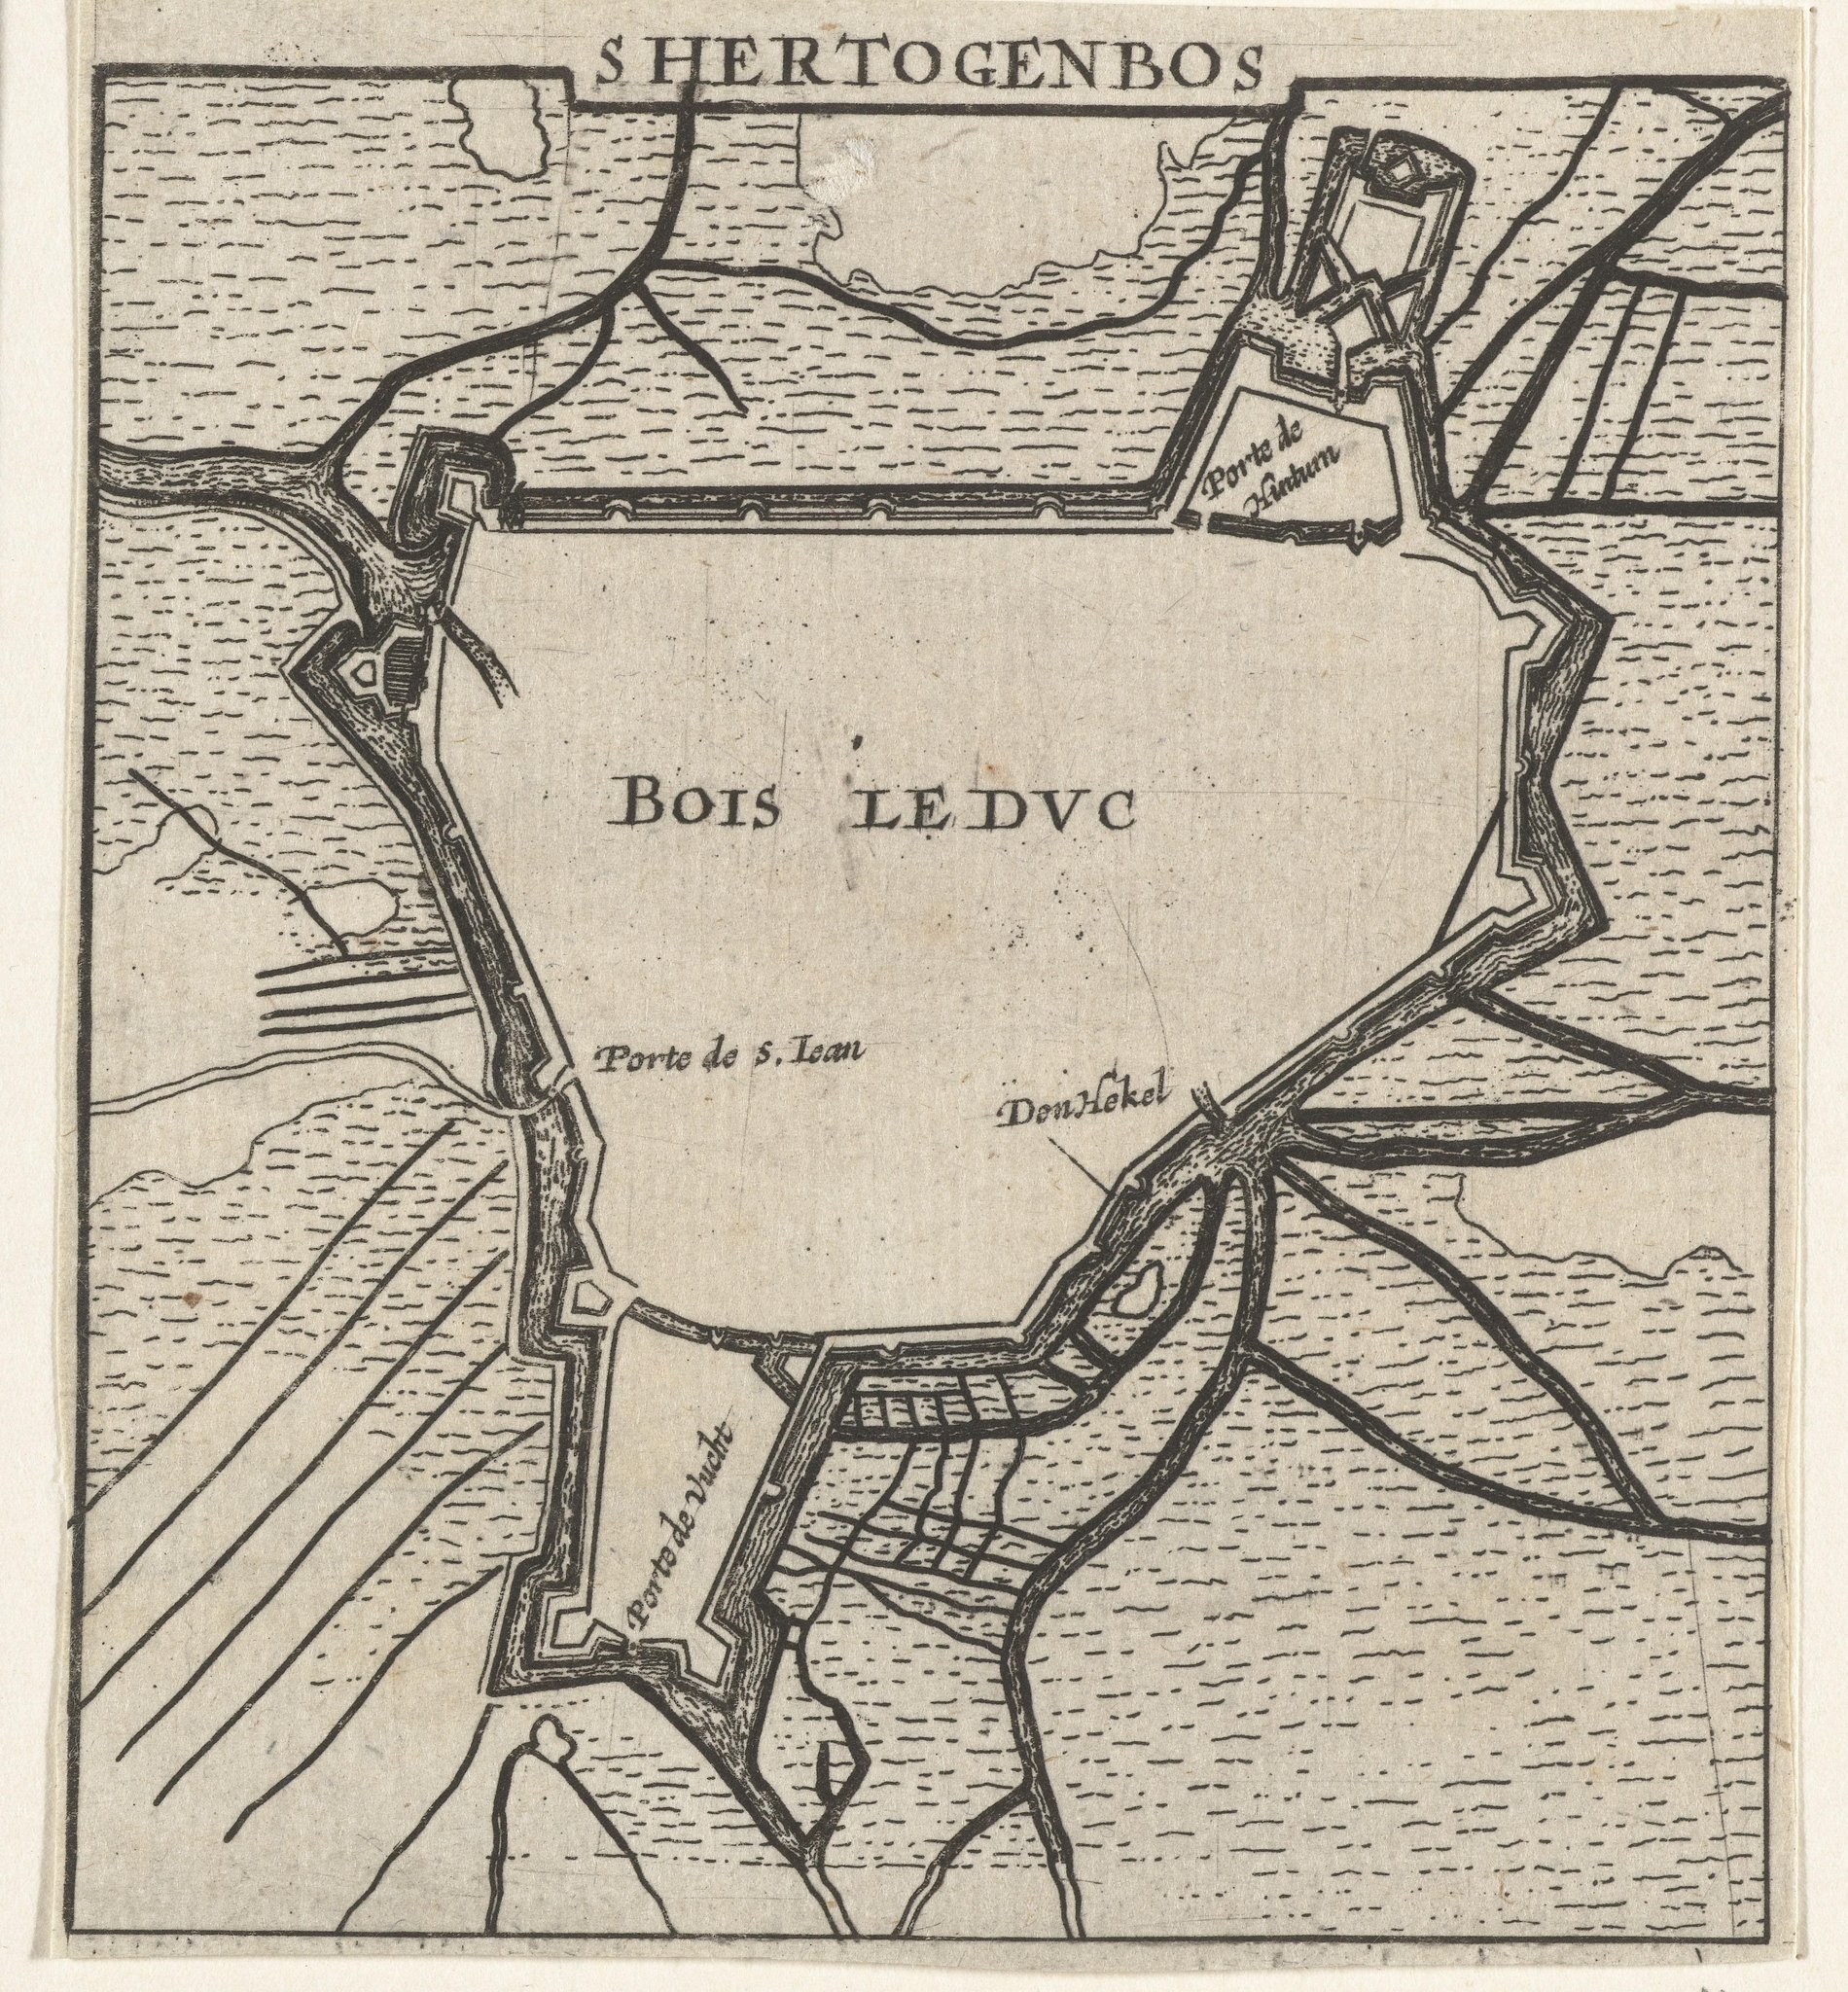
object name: map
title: Plattegrond van 's-Hertogenbosch, 1631-1632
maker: Anonymous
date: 1632-1649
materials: paper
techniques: etching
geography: northern netherlands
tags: maps of cities, den bosch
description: Plattegrond van 's-Hertogenbosch. Onderdeel van een groep plattegronden van steden, forten en dijken in Brabant veroverd door het Staatse leger onder Frederik Hendrik in de jaren 1631-1632.